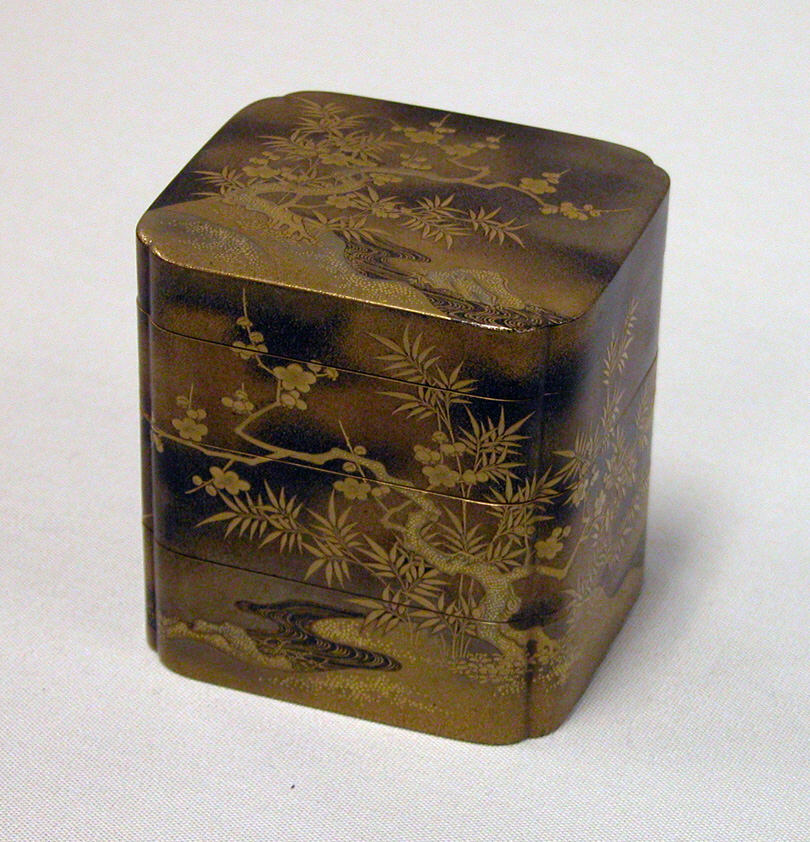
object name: incense box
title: Incense Box in Three Compartments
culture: japanese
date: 1834-1866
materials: gold, lacquer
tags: trees